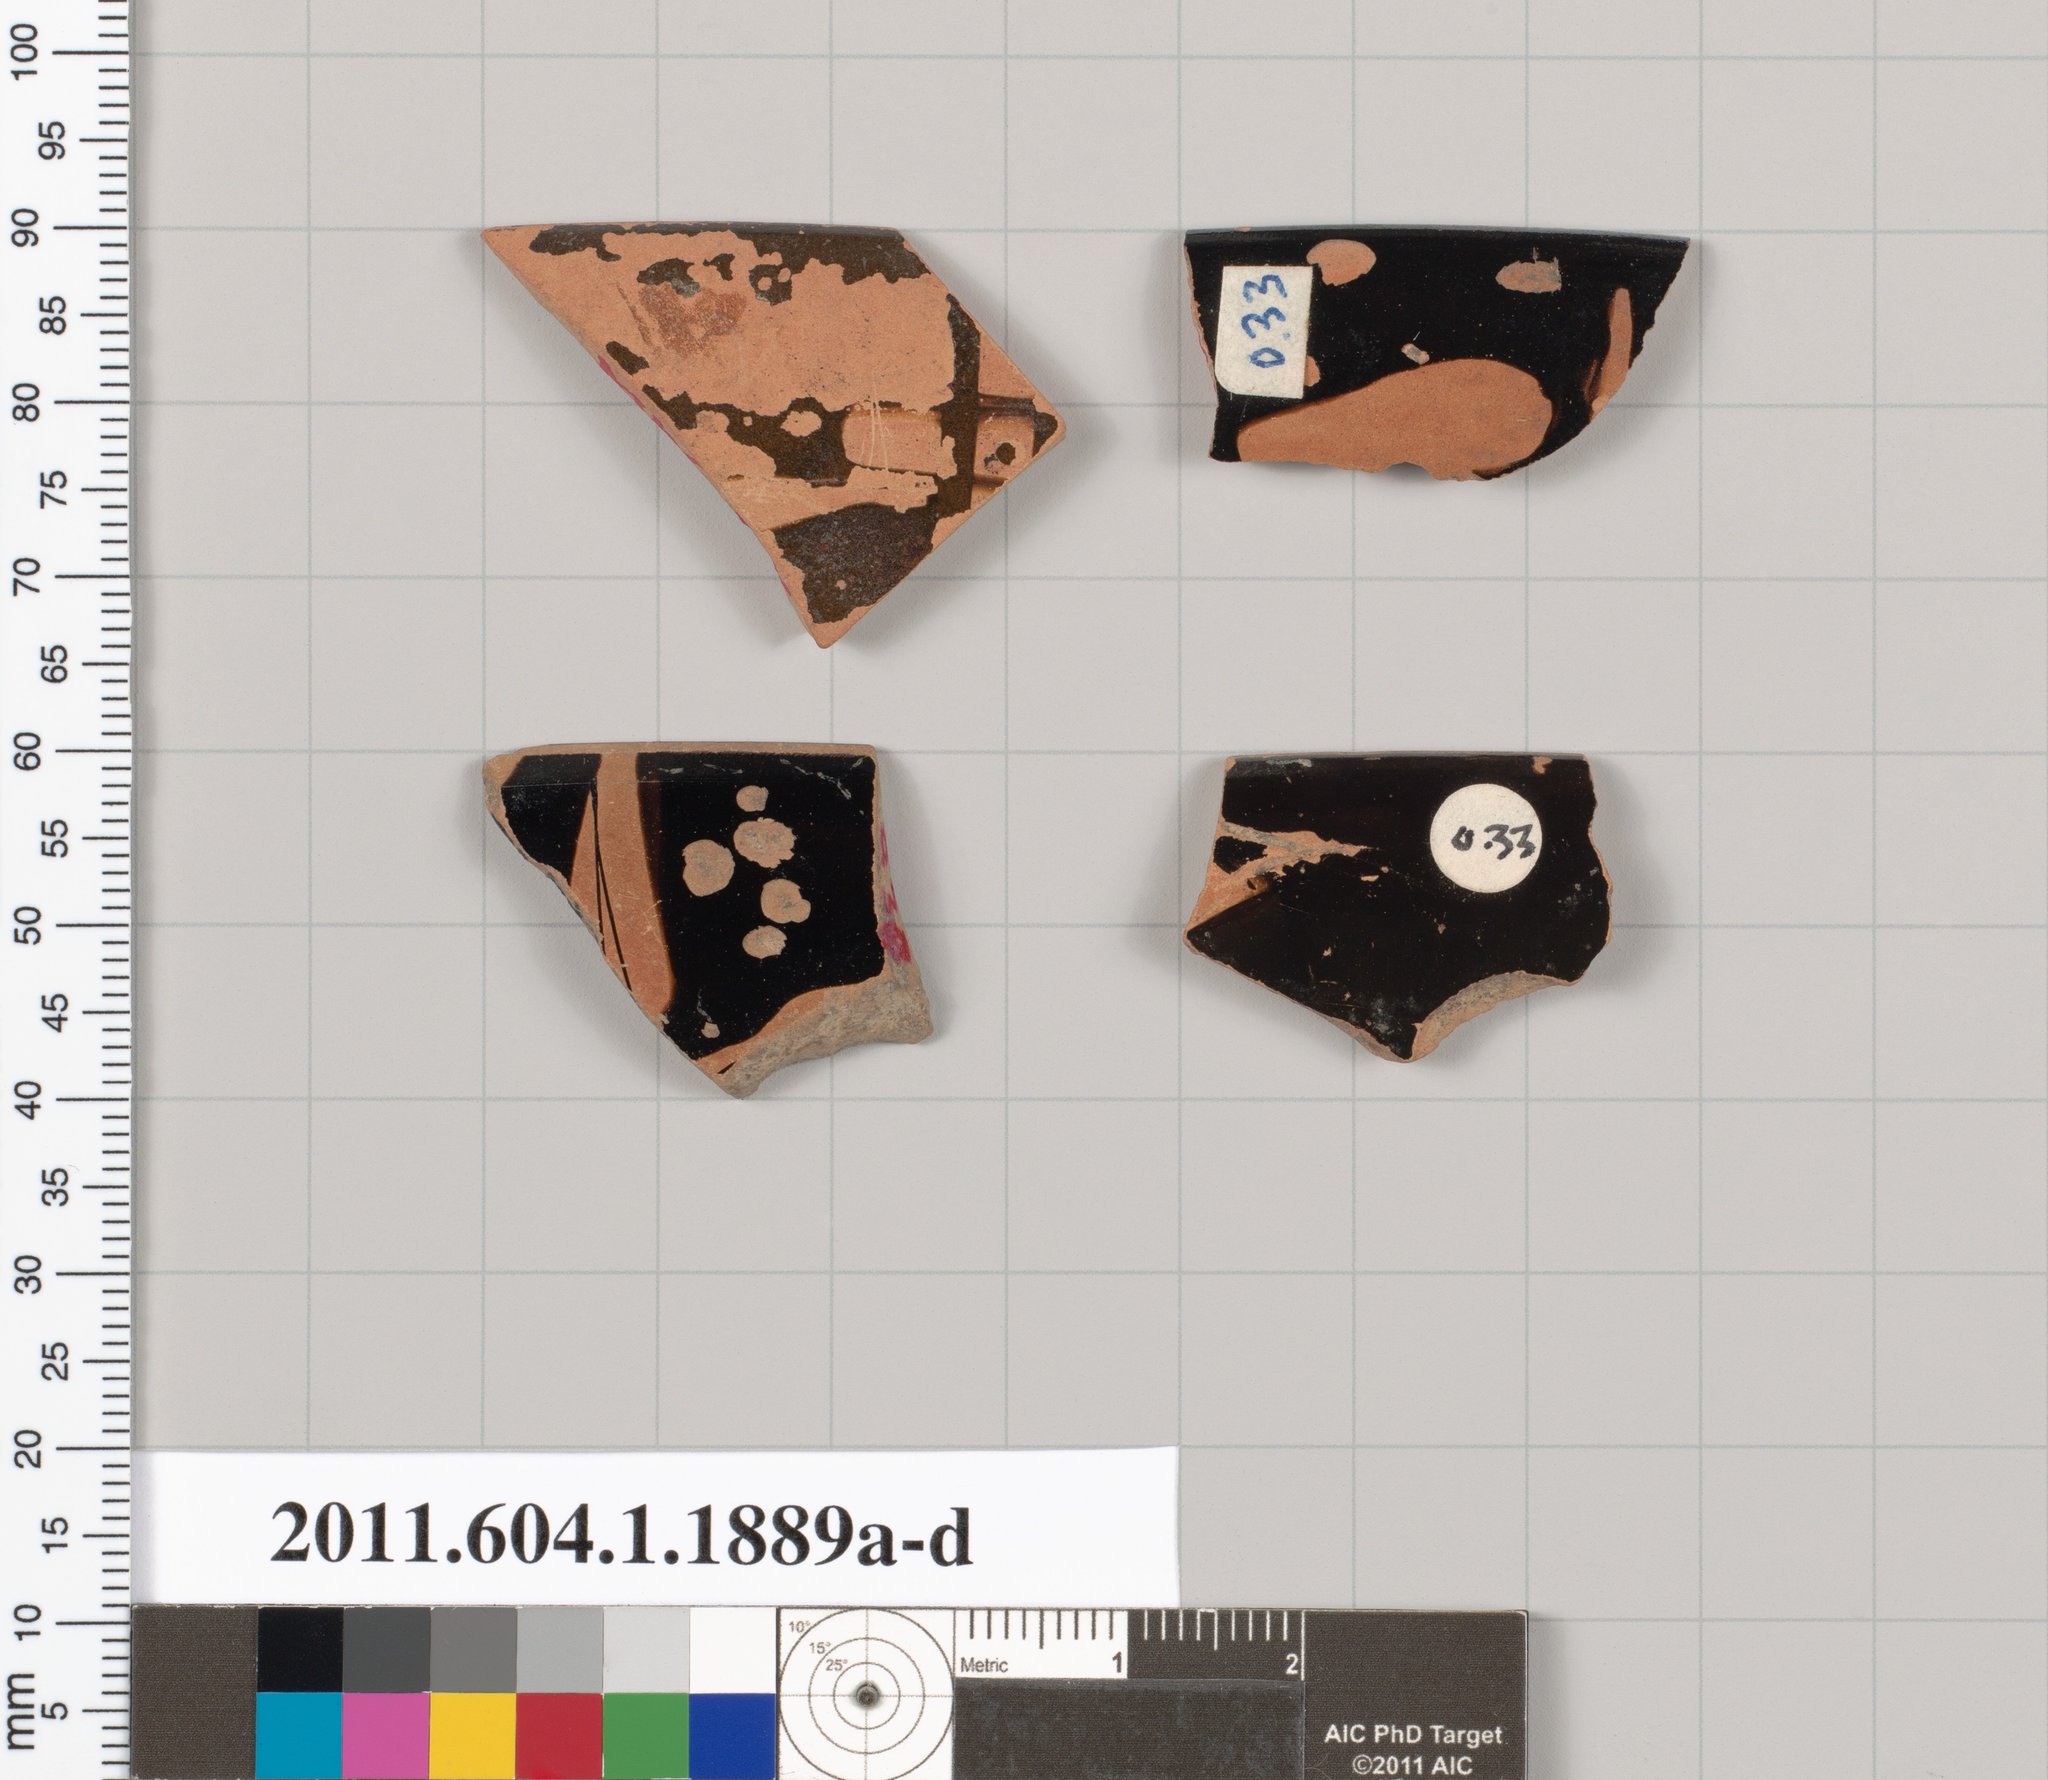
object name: kylix fragment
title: Terracotta rim fragments of kylikes (drinking cups)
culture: greek, attic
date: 500-401 BCE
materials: terracotta